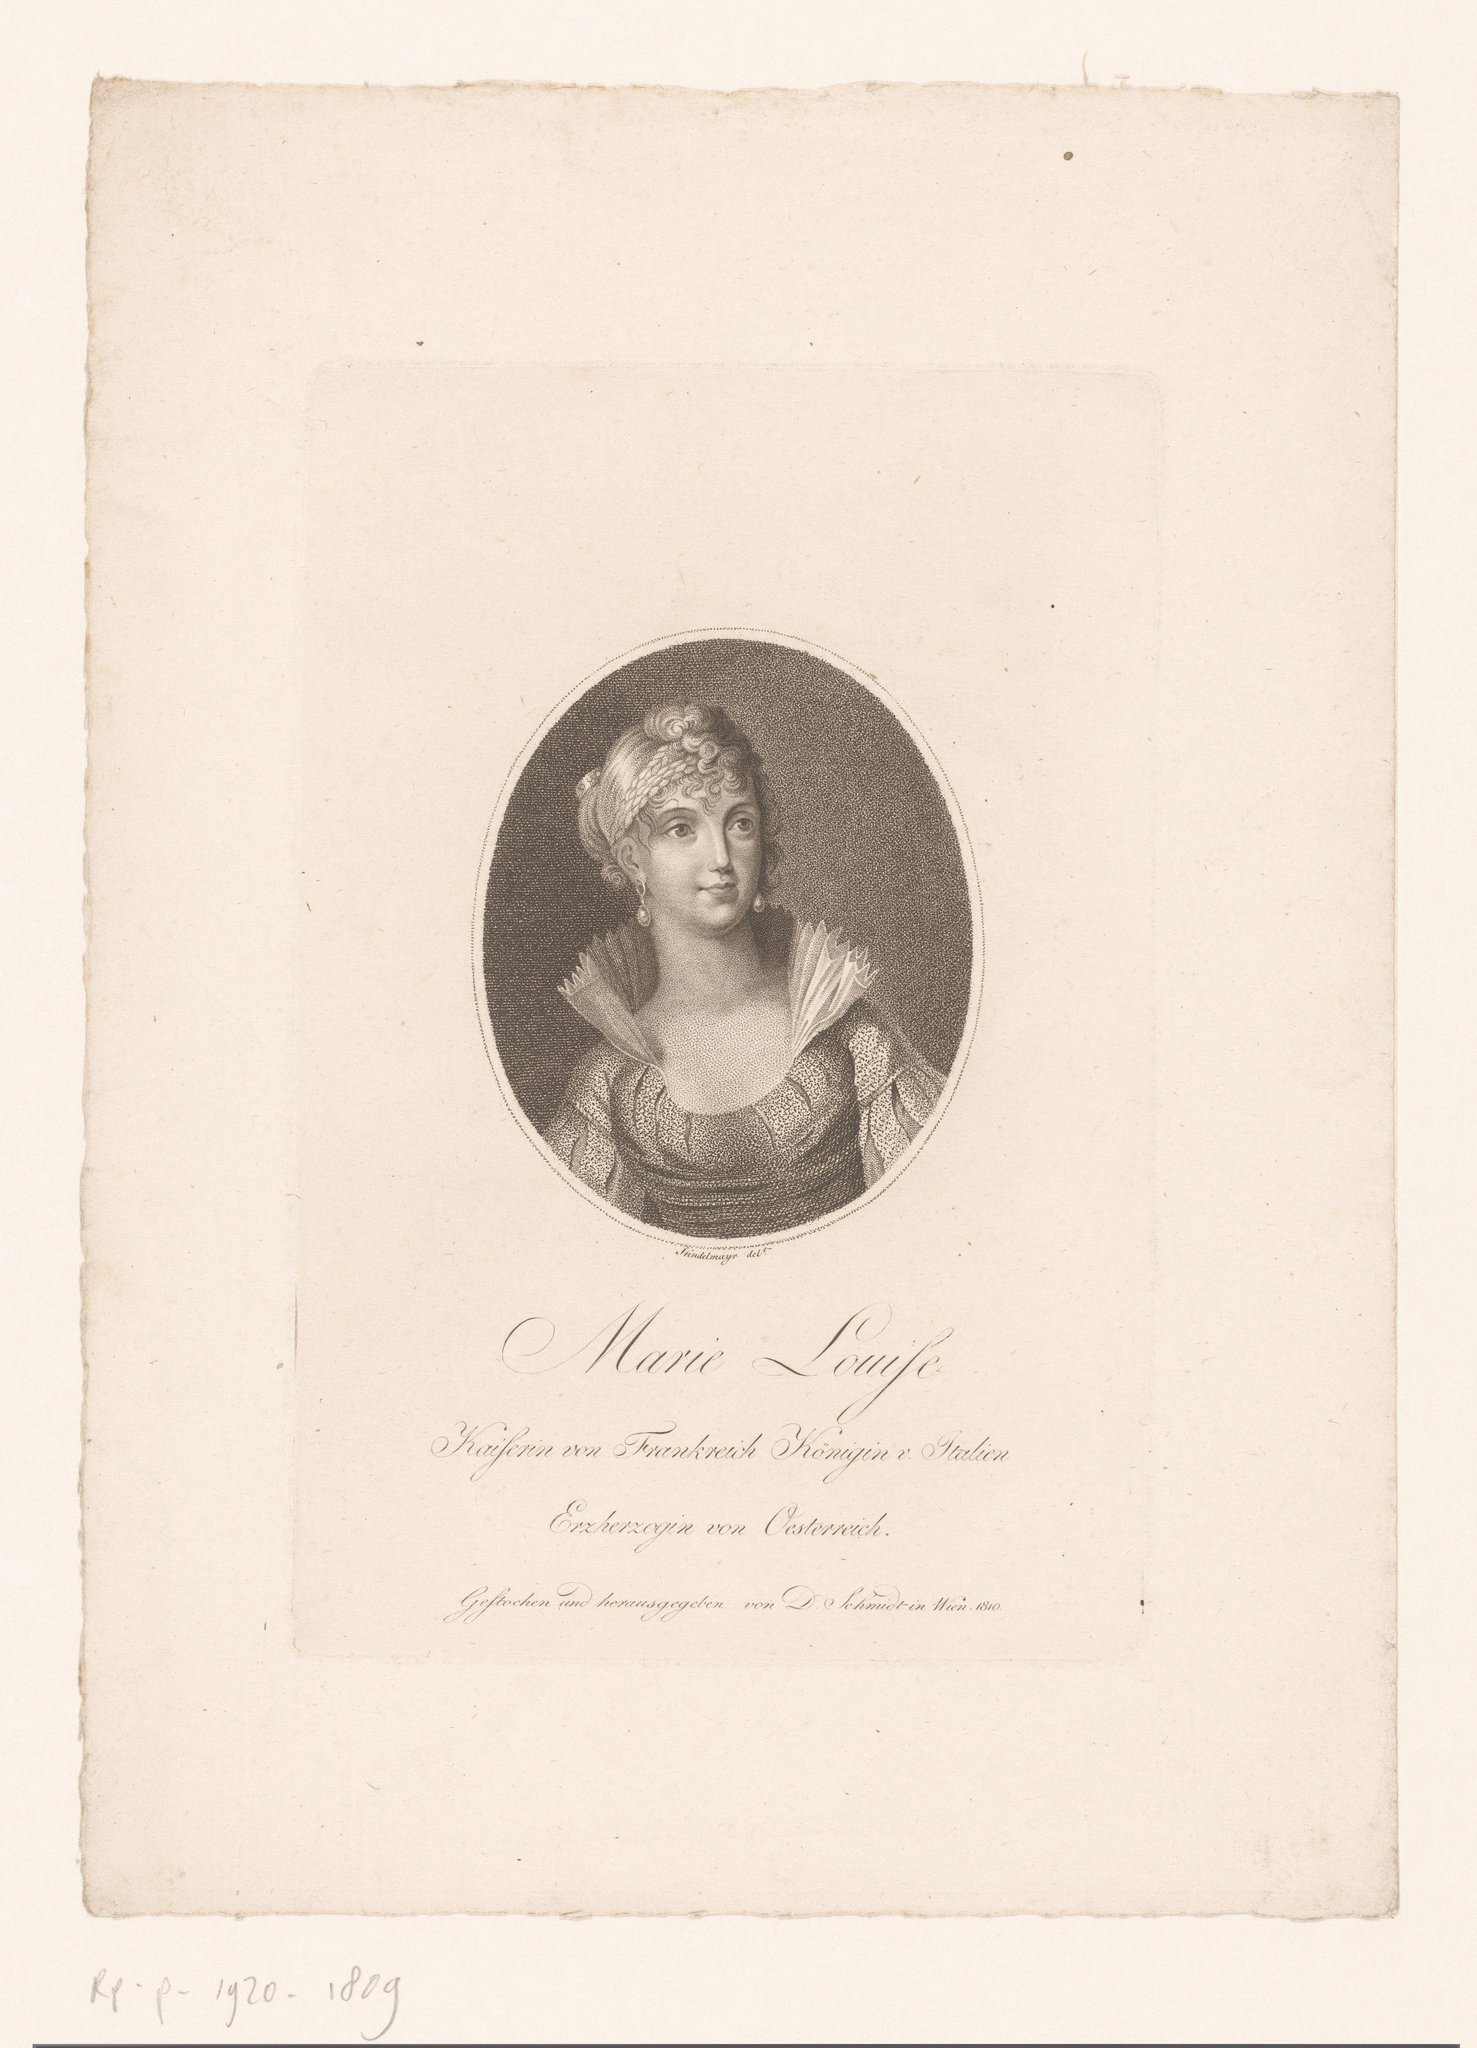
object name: print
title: Portret van Marie Louise van Oostenrijk, keizerin der Fransen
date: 1810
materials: paper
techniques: stippling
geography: vienna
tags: vienna, marie louise van oostenrijk (keizerin der fransen), historical persons - bb - woman, political caricatures and satires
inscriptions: collector's mark: Lugt 2228